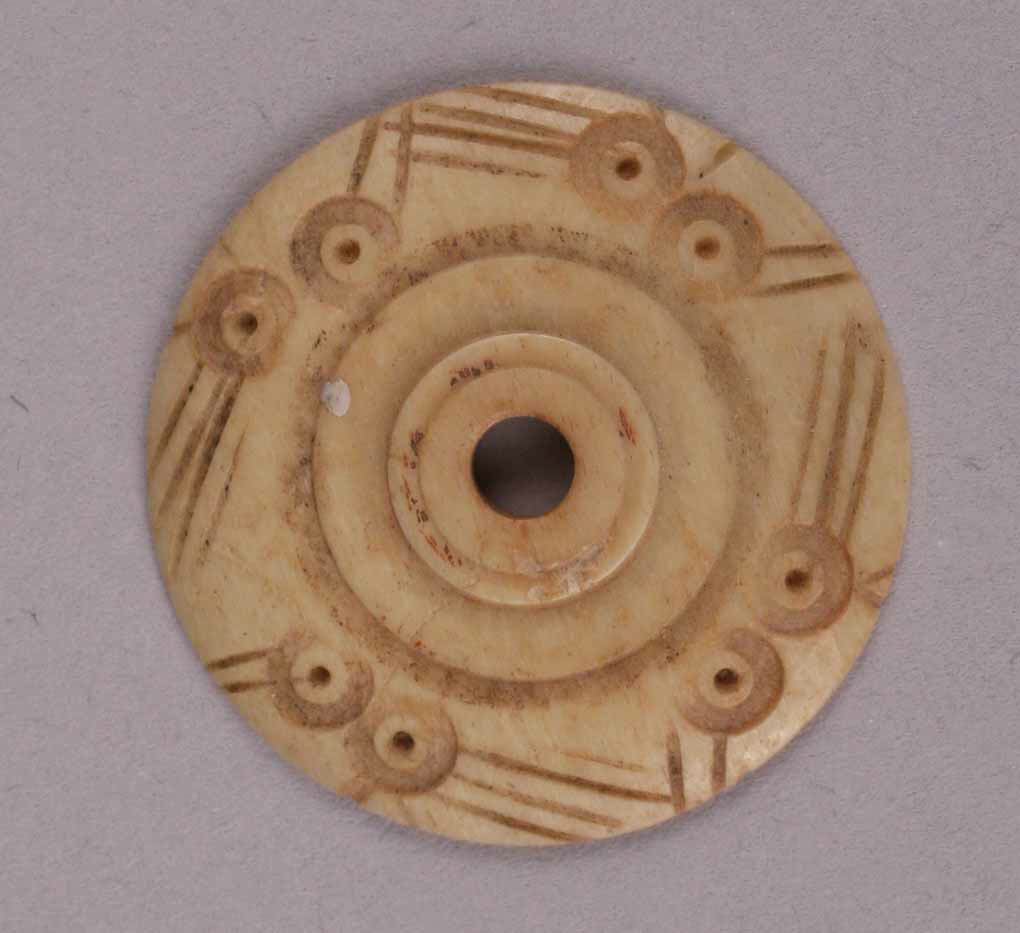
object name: button or bead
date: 801-1000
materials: bone, paint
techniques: incising, inlay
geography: iran